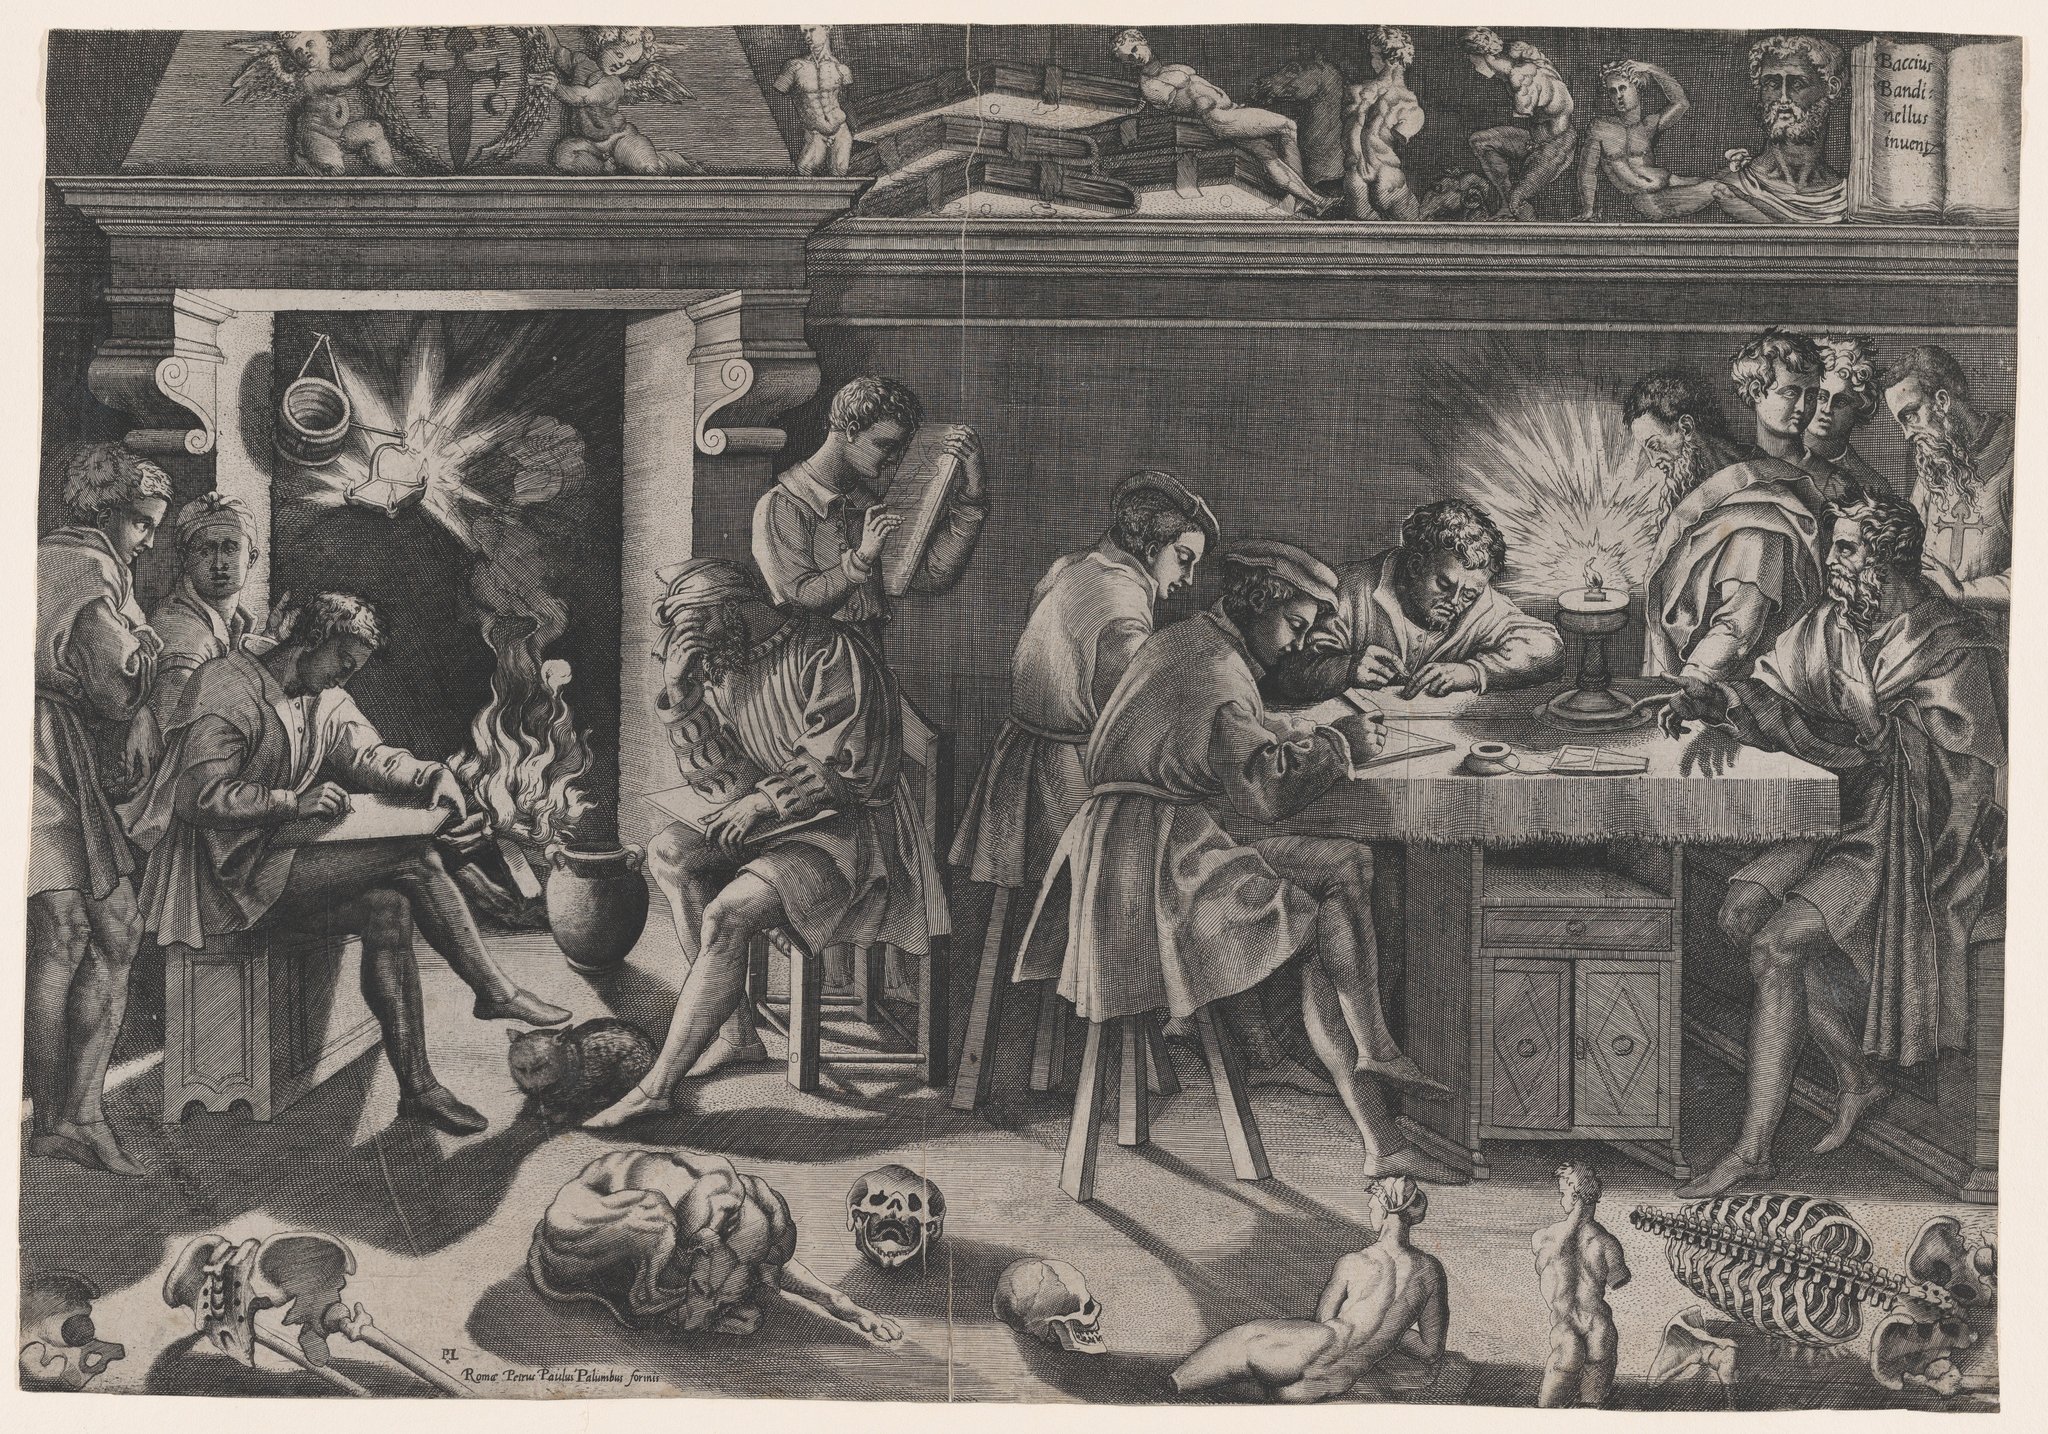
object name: print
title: The Academy of Baccio Bandinelli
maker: enea vico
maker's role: artist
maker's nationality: italian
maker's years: 1523-1567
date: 1544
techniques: engraving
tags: fireplaces,skeletons,men,women